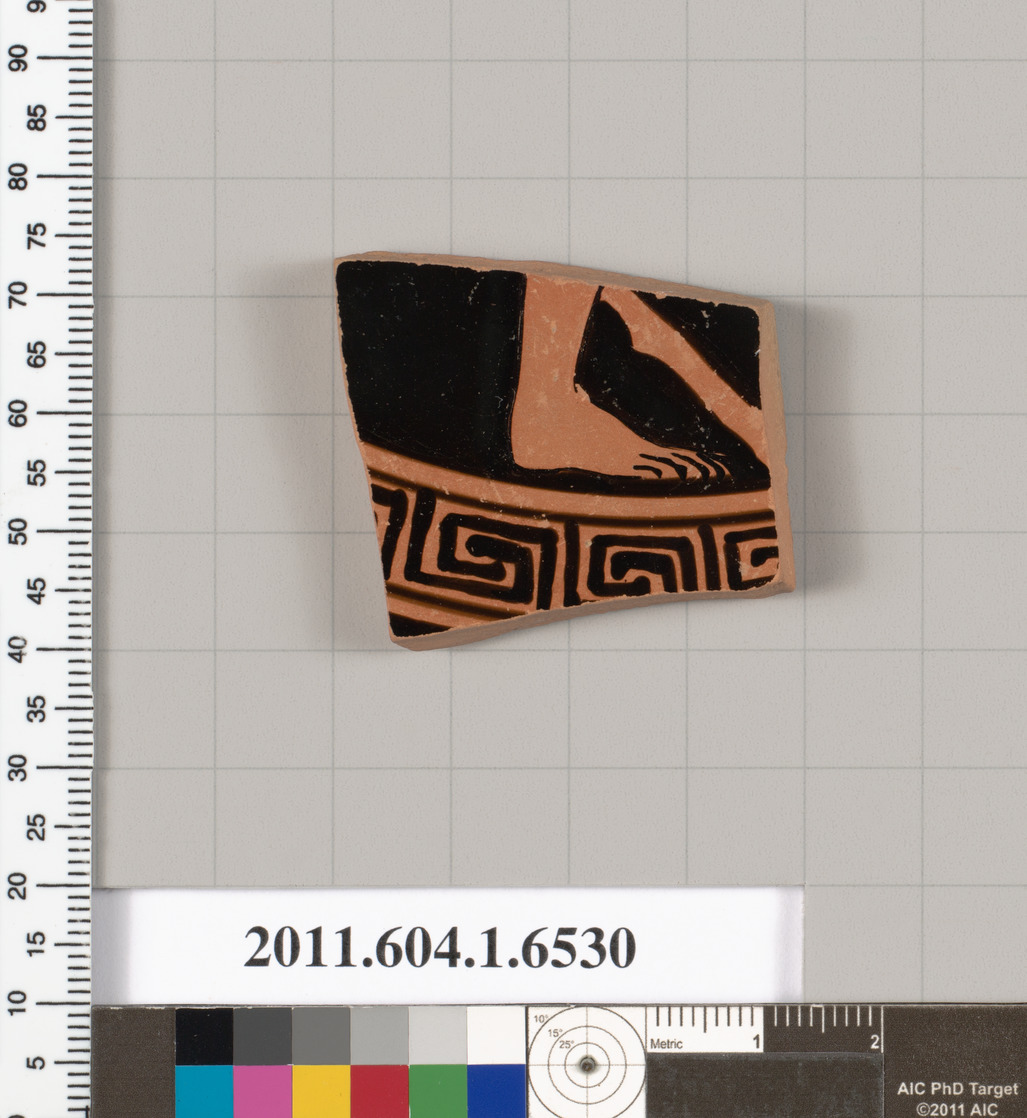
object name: kylix fragment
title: Terracotta fragment of a kylix (drinking cup)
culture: greek, attic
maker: colmar painter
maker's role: artist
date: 490-480 BCE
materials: terracotta